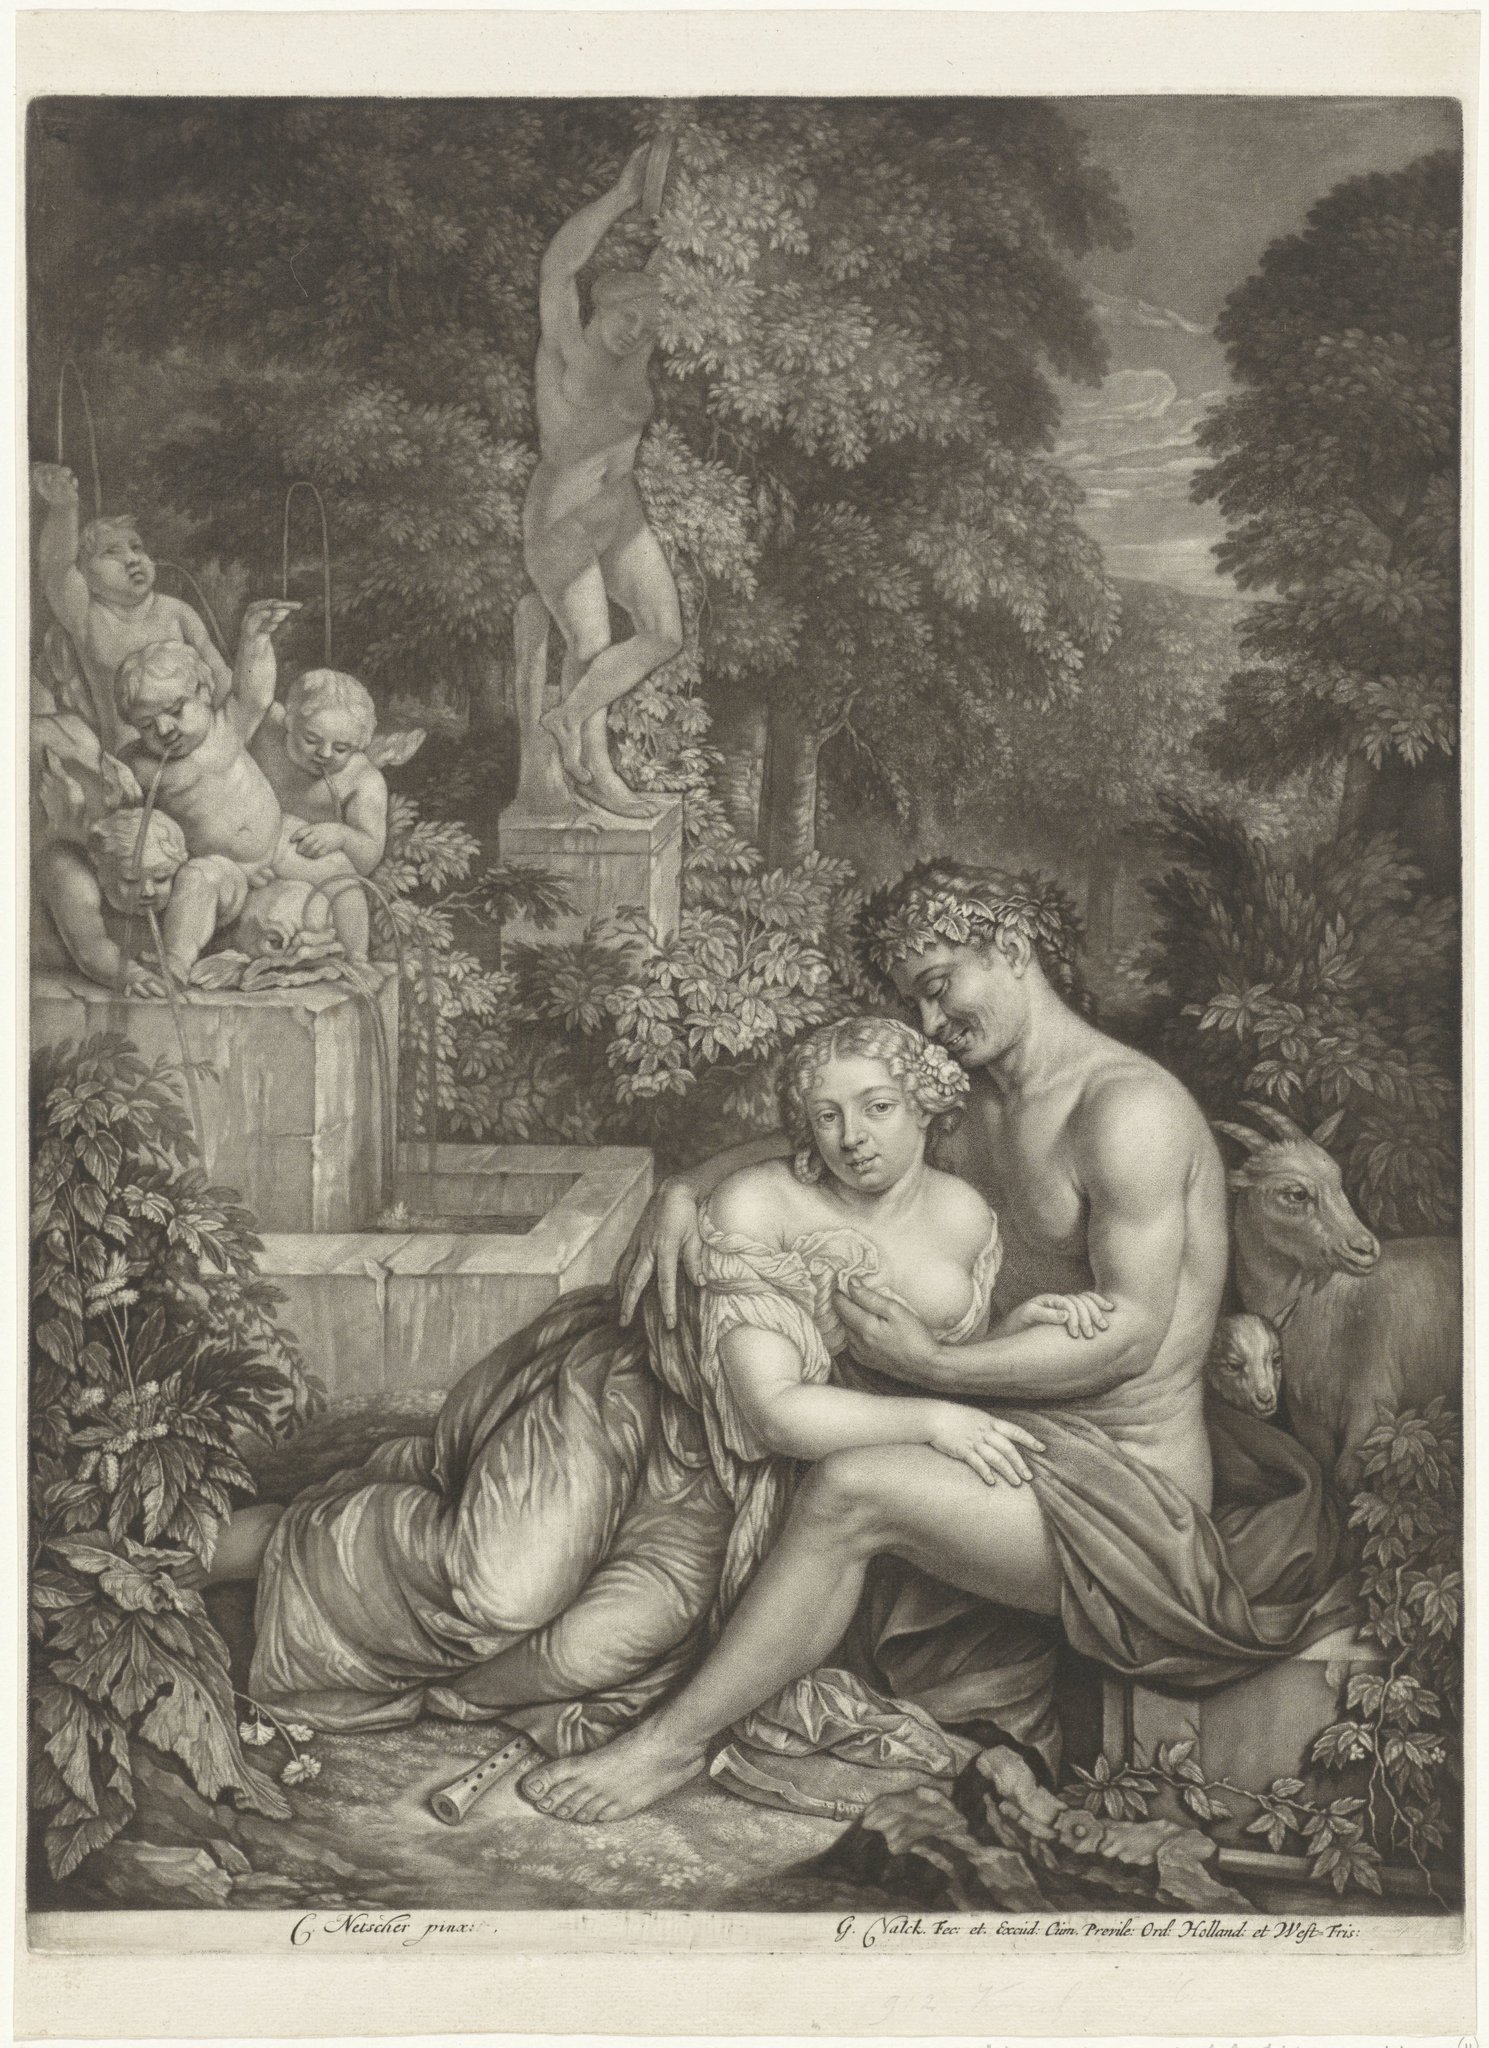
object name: print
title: Vertumnus en Pomona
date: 1681-1726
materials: paper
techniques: mezzotint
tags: vertumnus and pomona, goat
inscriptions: collector's mark: Lugt 2228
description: Vertumnus, de Italiaanse god en beschermer van tuinen en boomgaarden, en Pomona zitten in intieme houding bij een fontein in een tuin. Achter hen staan twee geiten.